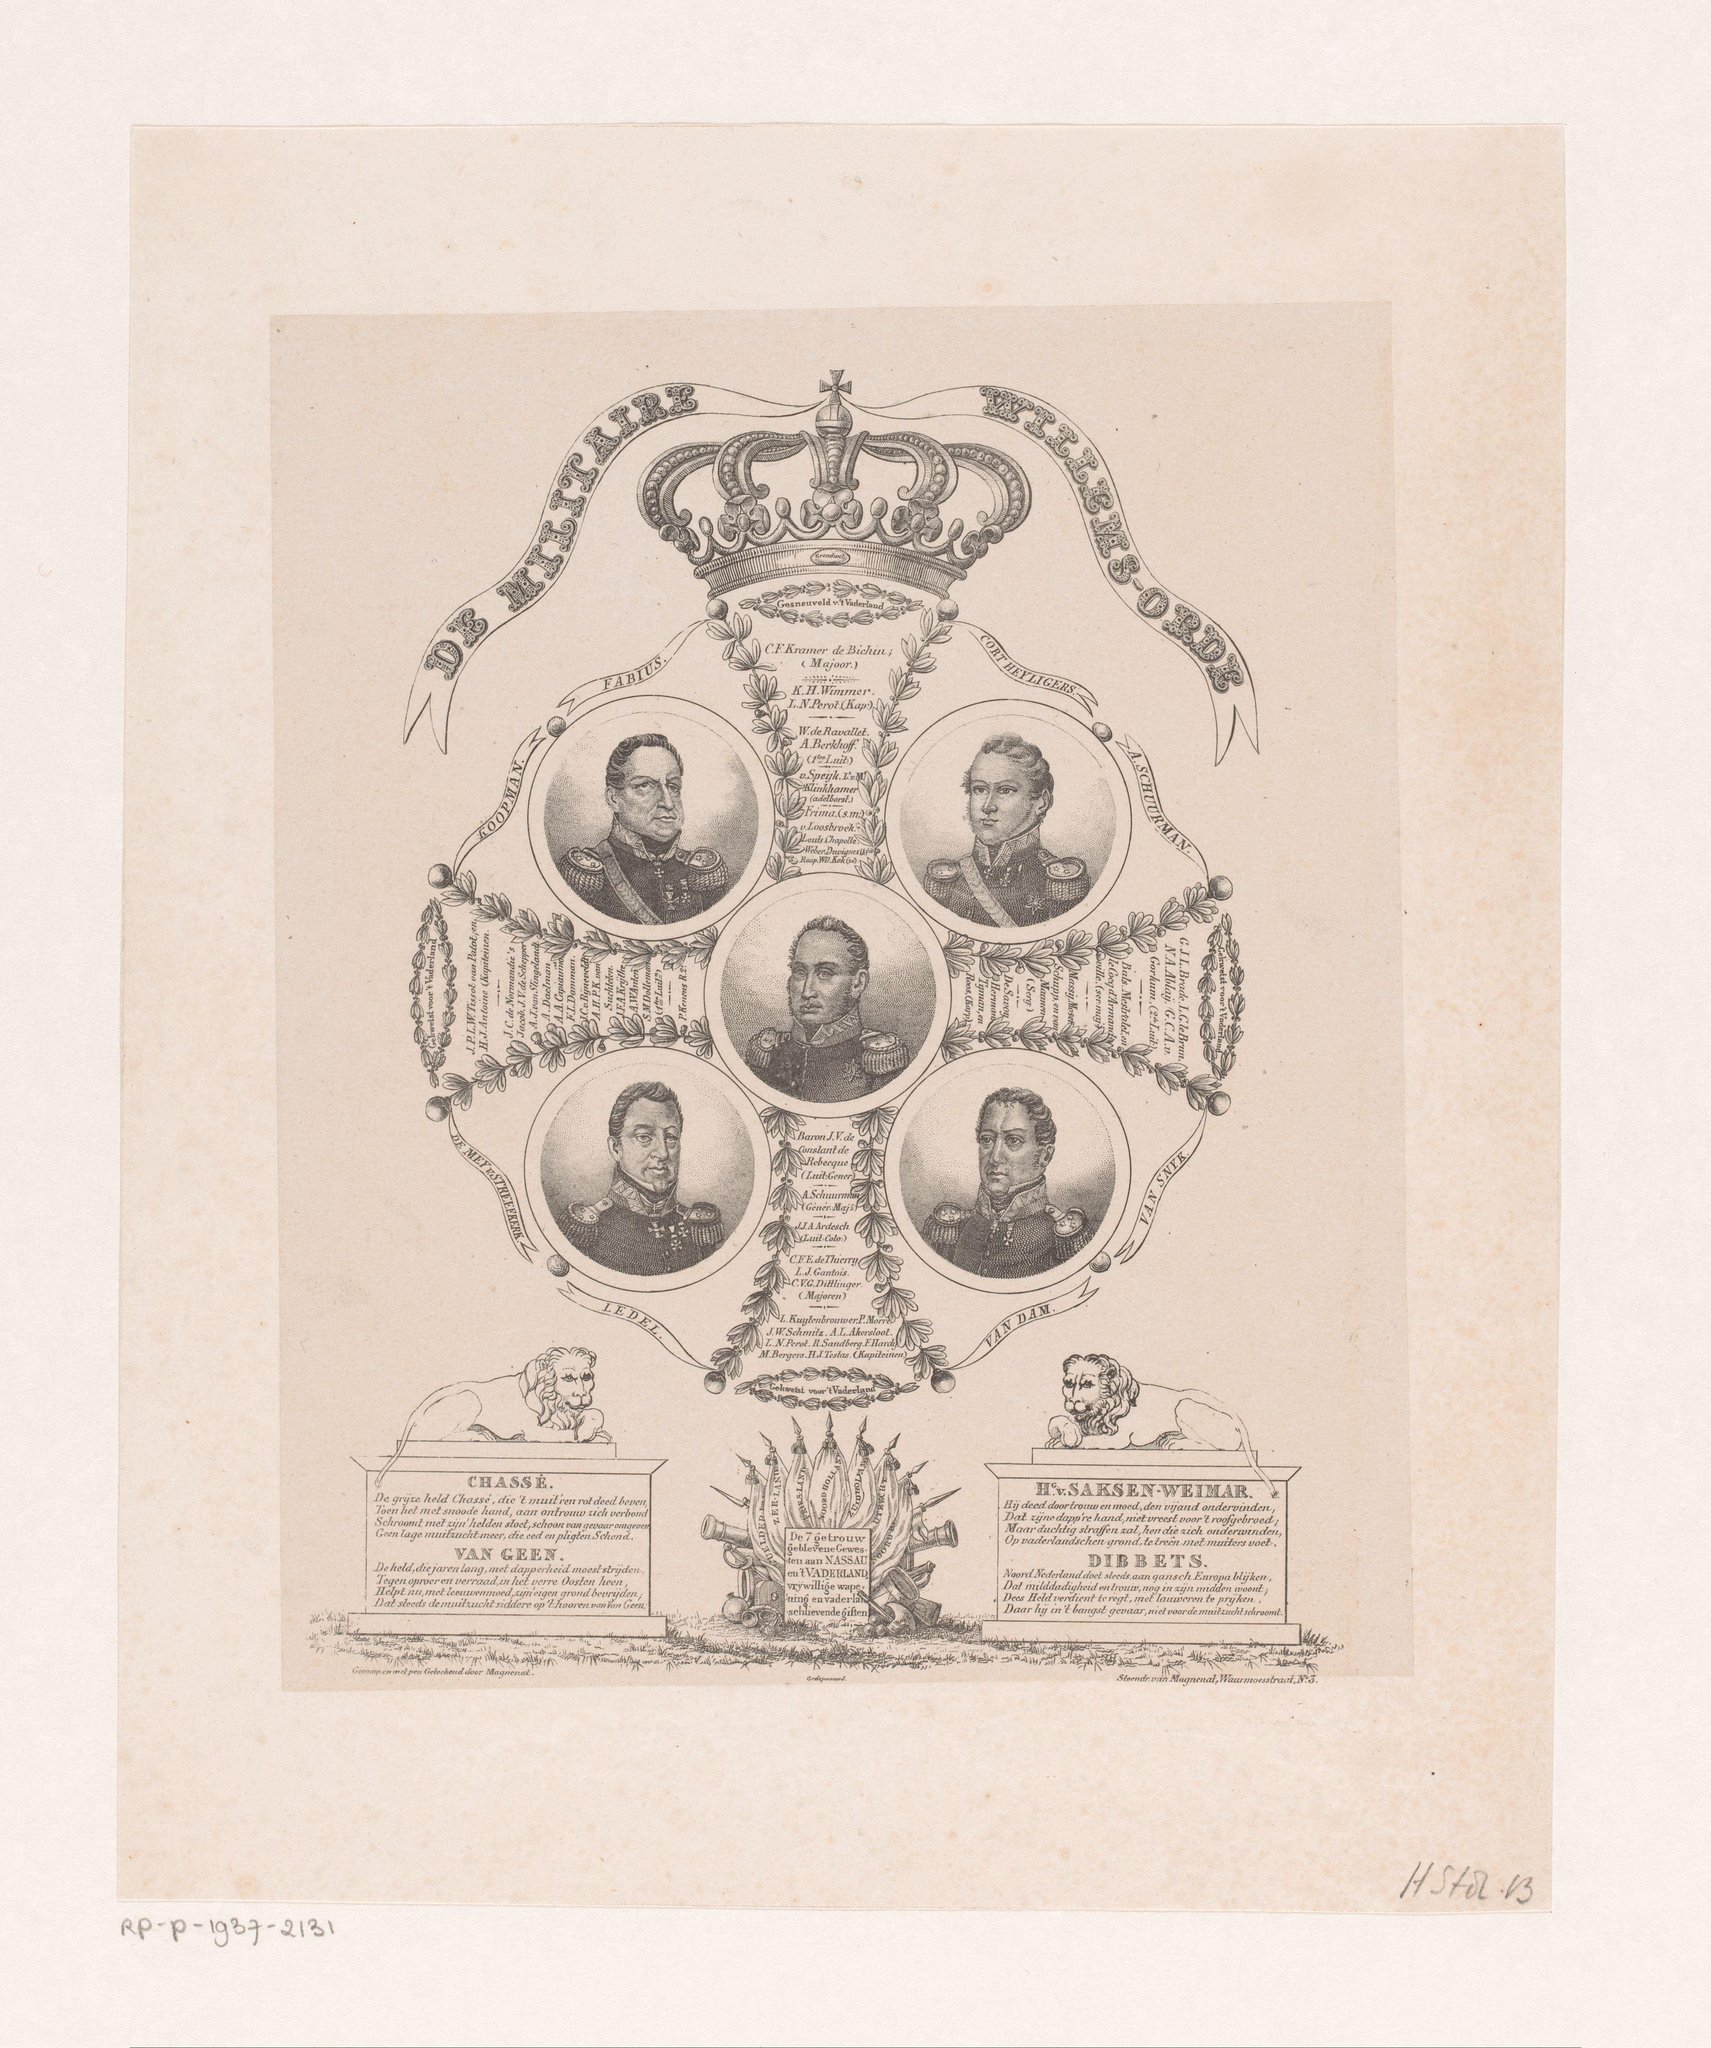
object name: print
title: Lijst met soldaten die de Militaire Willemsorde ontvingen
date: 1815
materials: paper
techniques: lithograph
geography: amsterdam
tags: david hendrik baron chassé, the hague, berlin, william i of the netherlands, historical persons (+ head (and shoulders) (portrait)), knighthood order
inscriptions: collector's mark: Lugt 2760, collector's mark: Lugt 2228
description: Tussen de namen van soldaten die gekwetst of gesneuveld zijn prijken vijf portretten van Chassé, Van Saksen-Weimar, Dibbets en Van Geen. In het midden Koning Willem I. Links- en rechtsonder tombes of voetstukken met daarop twee leeuwen en dichtregels over de generaals. Midden onder vaandels die de zeven getrouwe gewesten symboliseren.